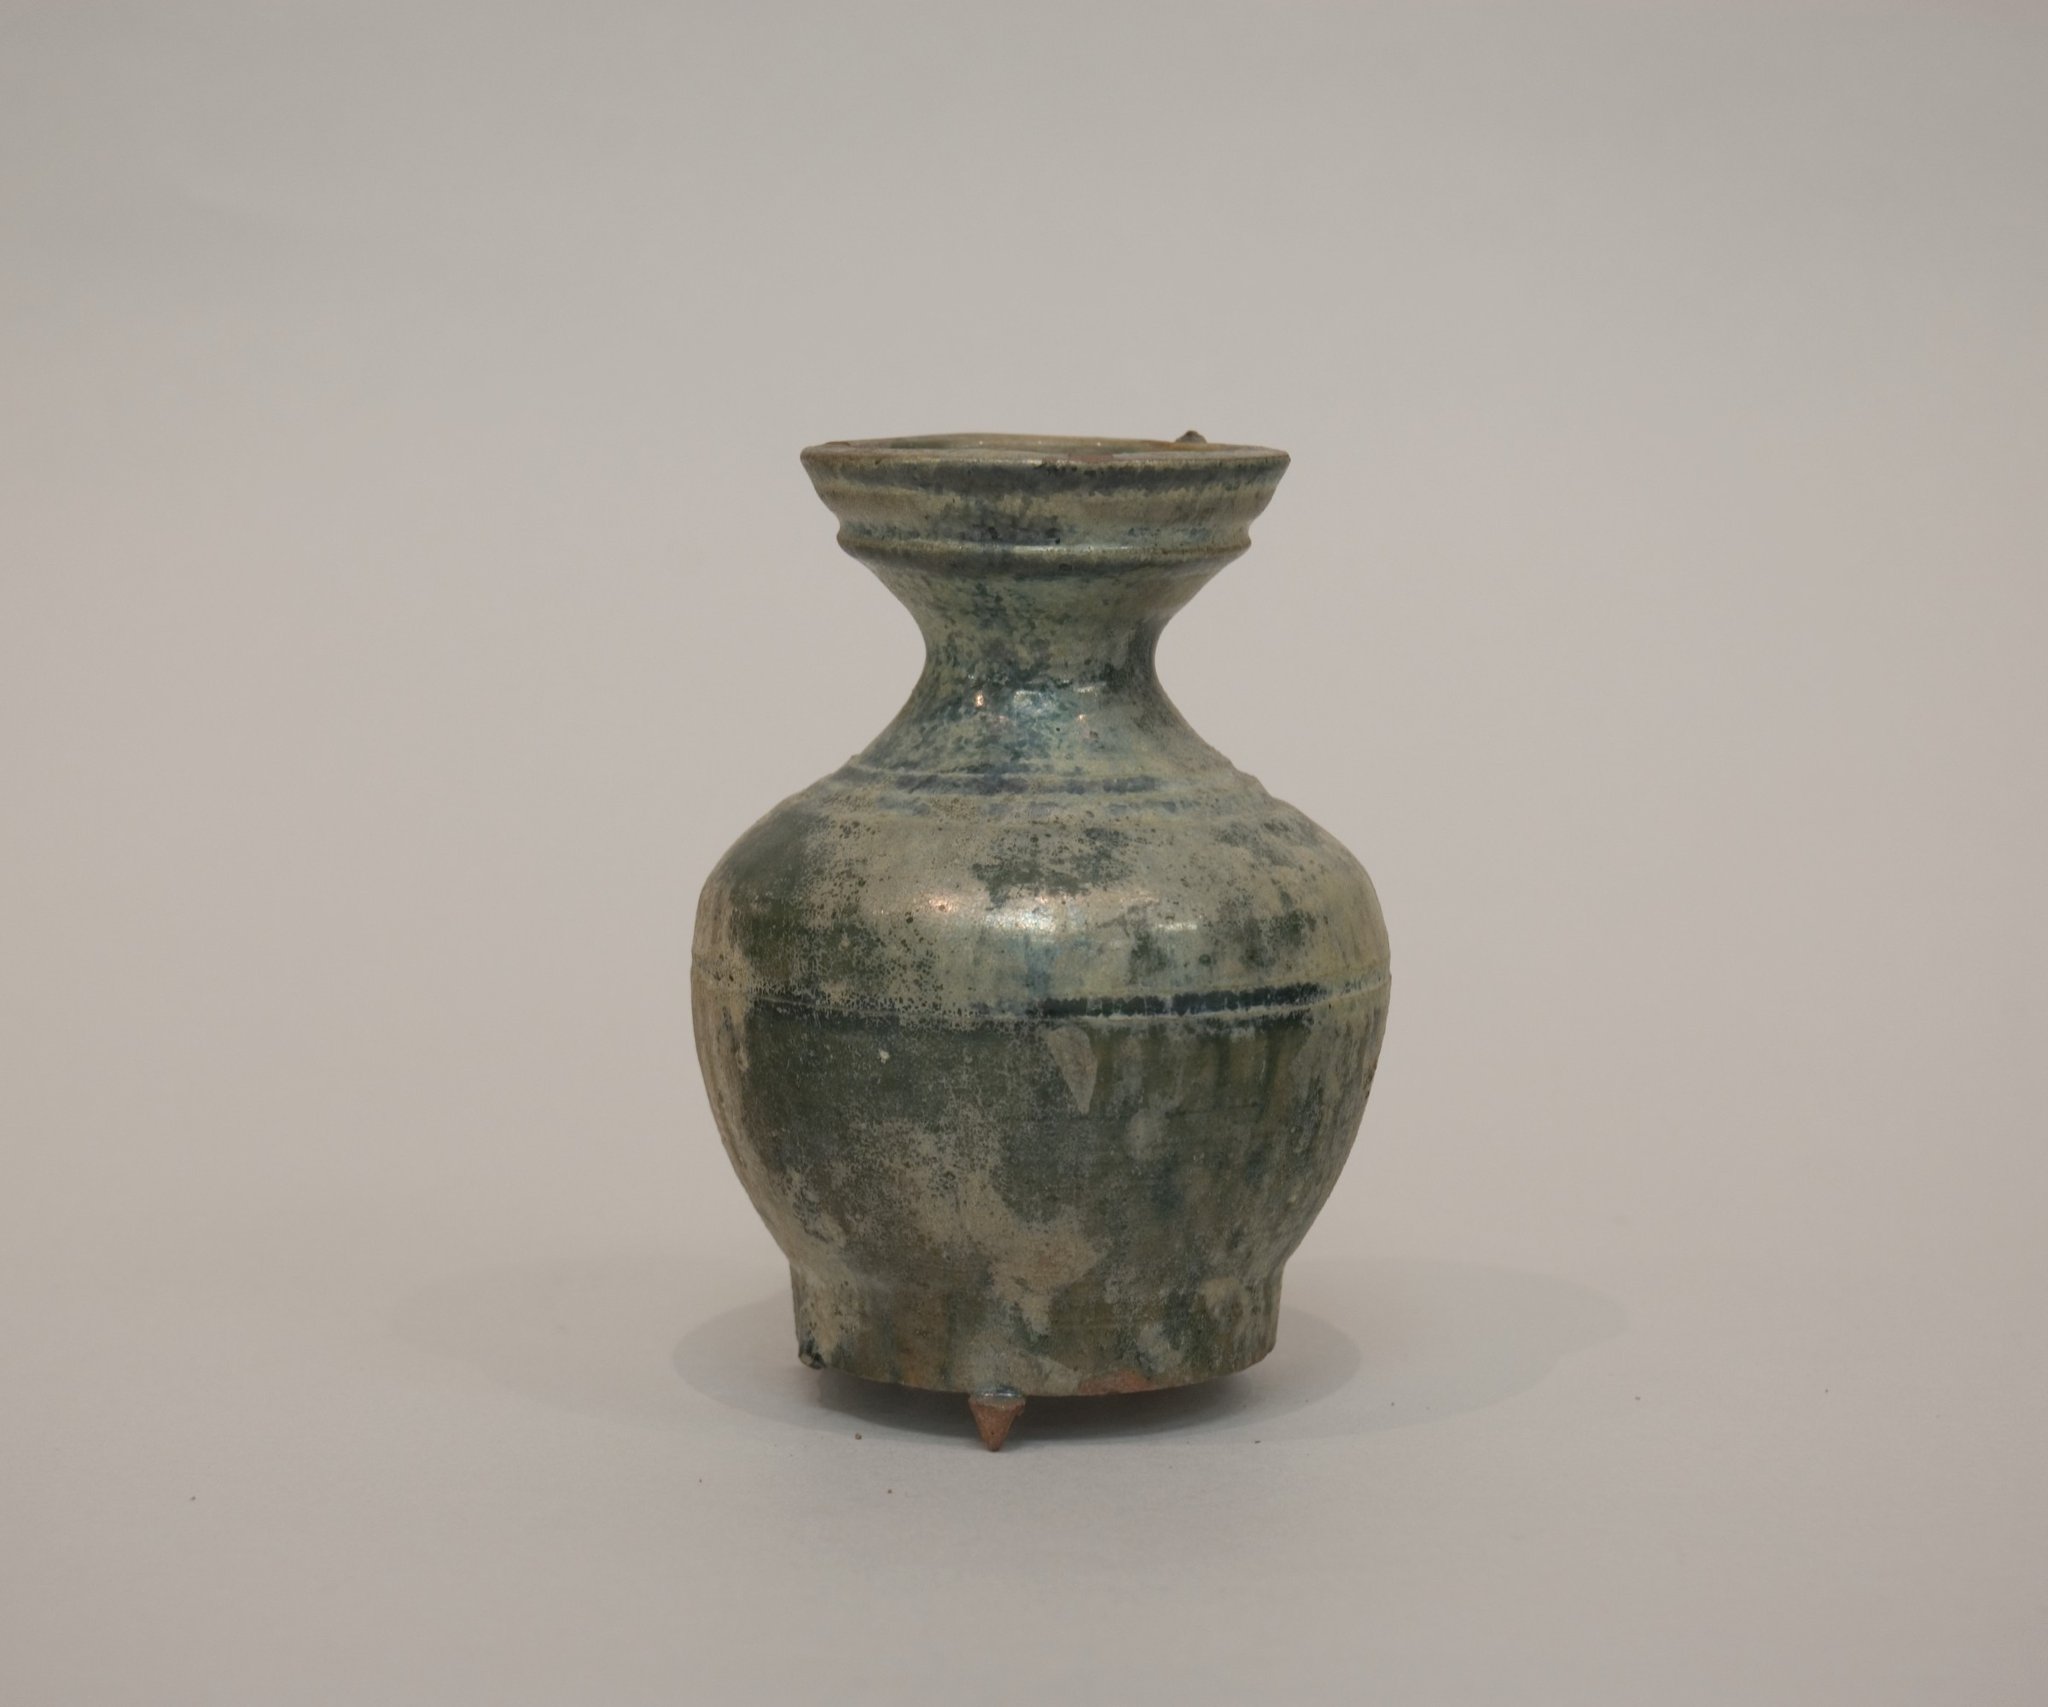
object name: vase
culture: chinese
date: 206 BCE-220 CE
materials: pottery